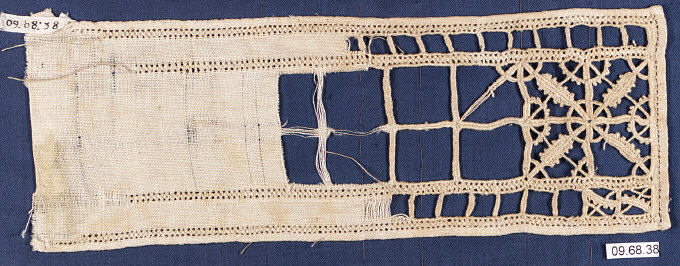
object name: sampler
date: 1801-1900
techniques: lace